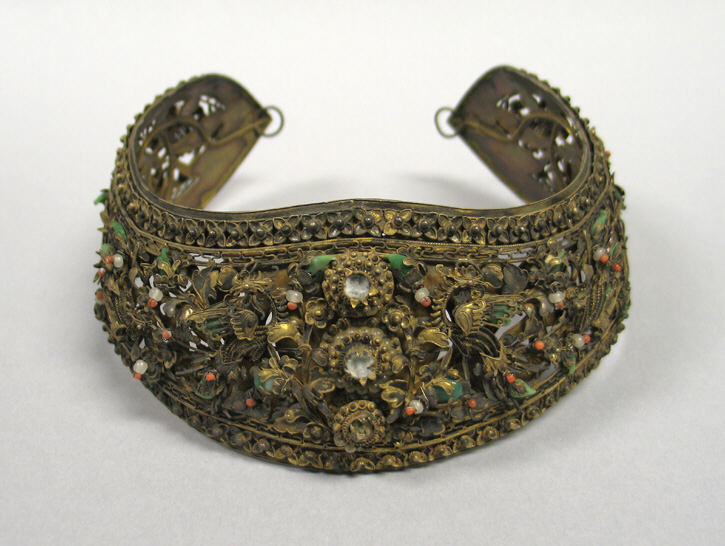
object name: burial crown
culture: chinese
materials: silver gilt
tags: crabs,fish,crowns